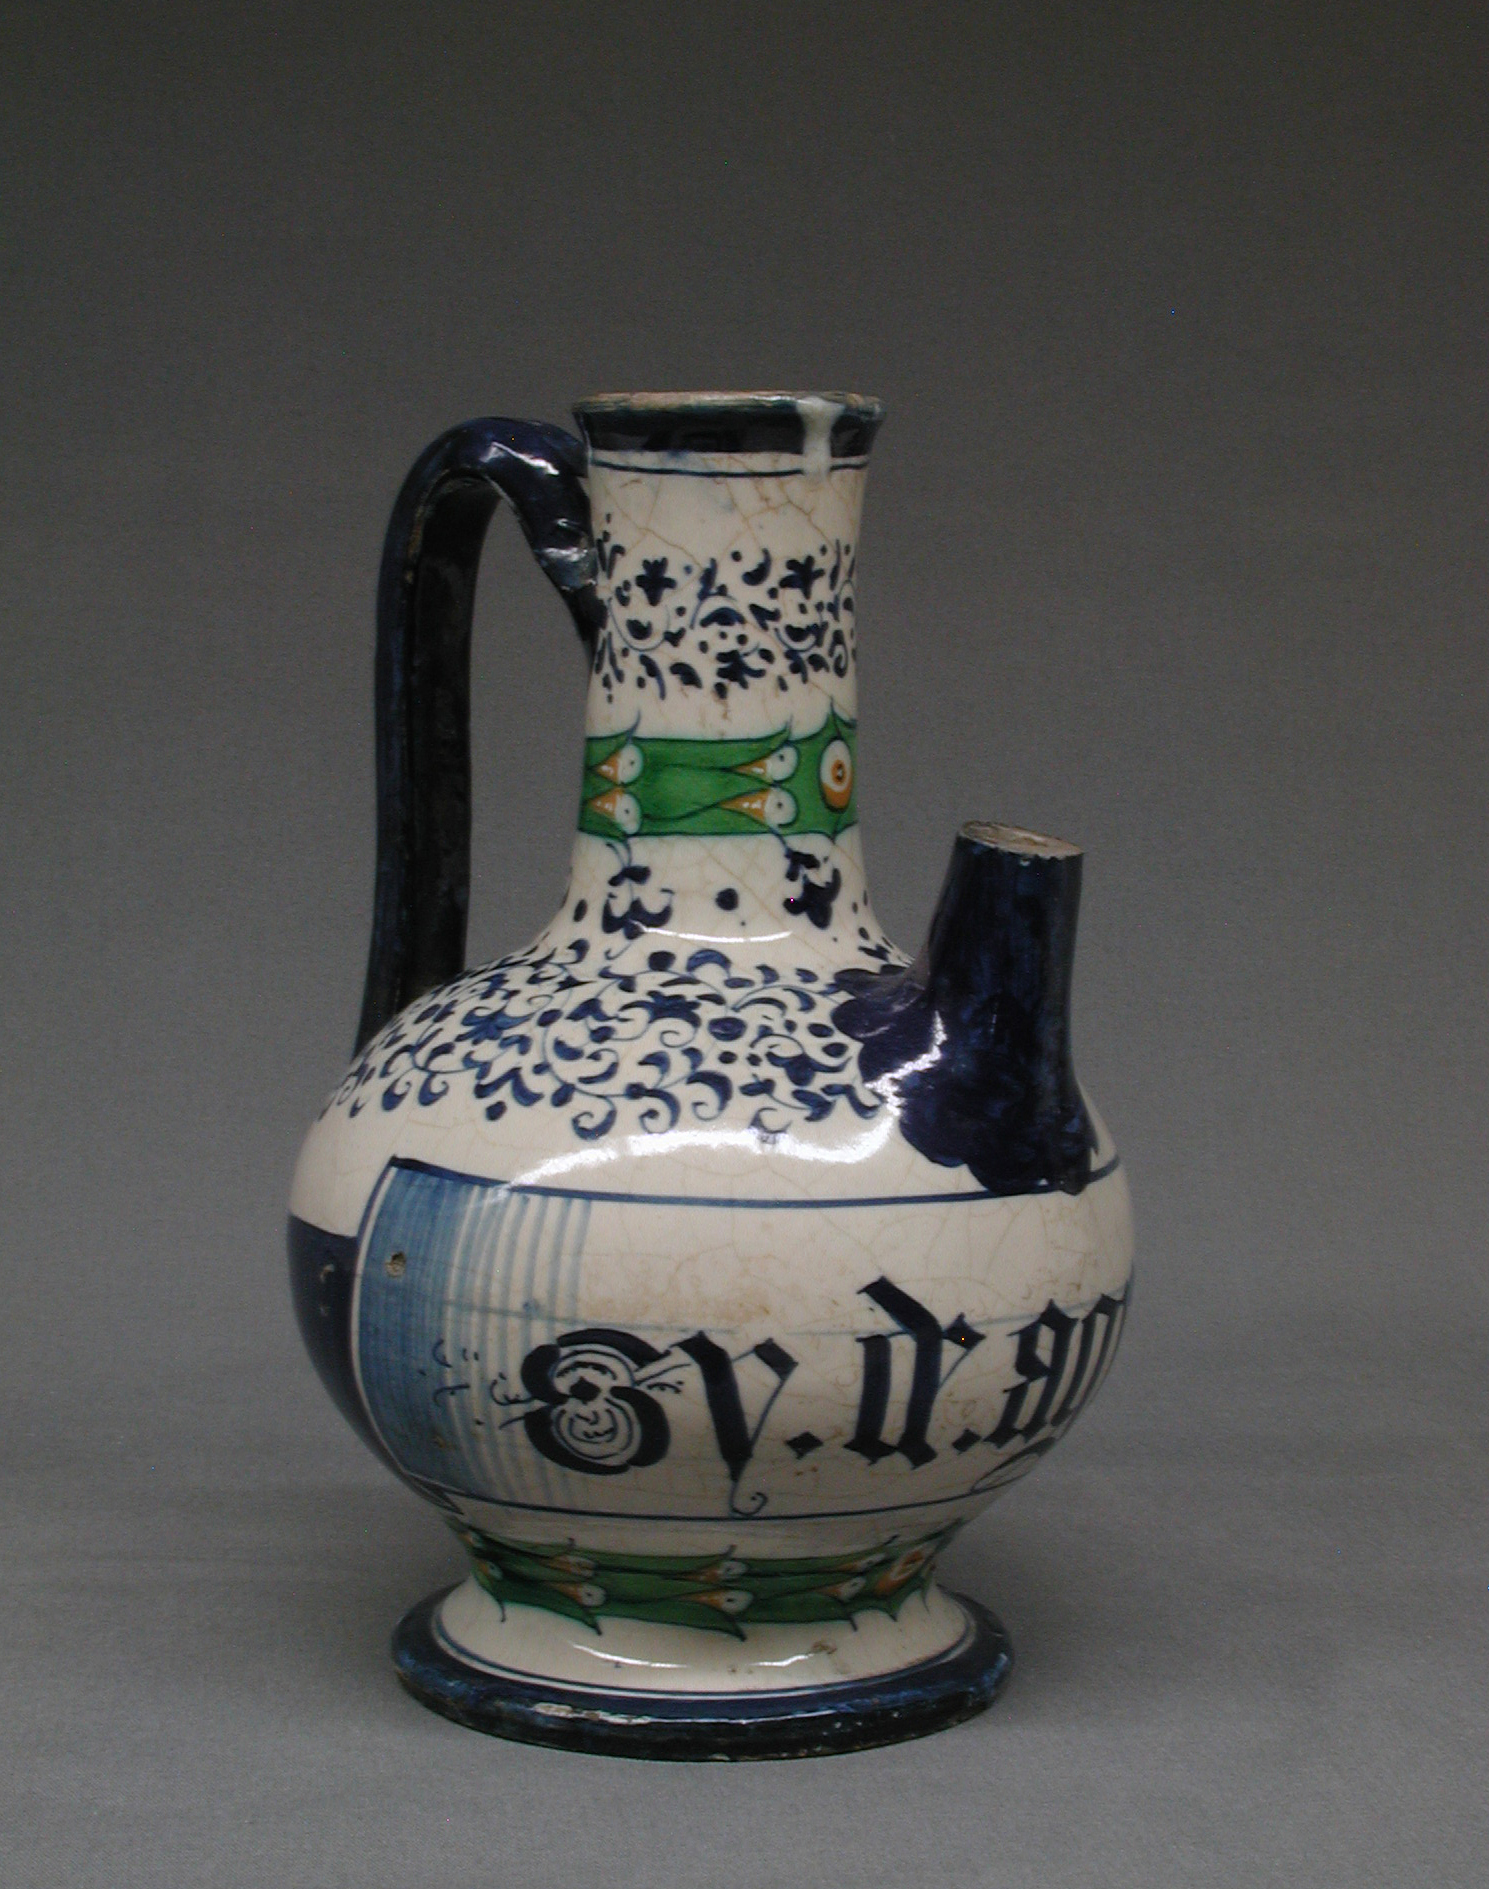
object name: ewer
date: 1501-1600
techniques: maiolica, glazing